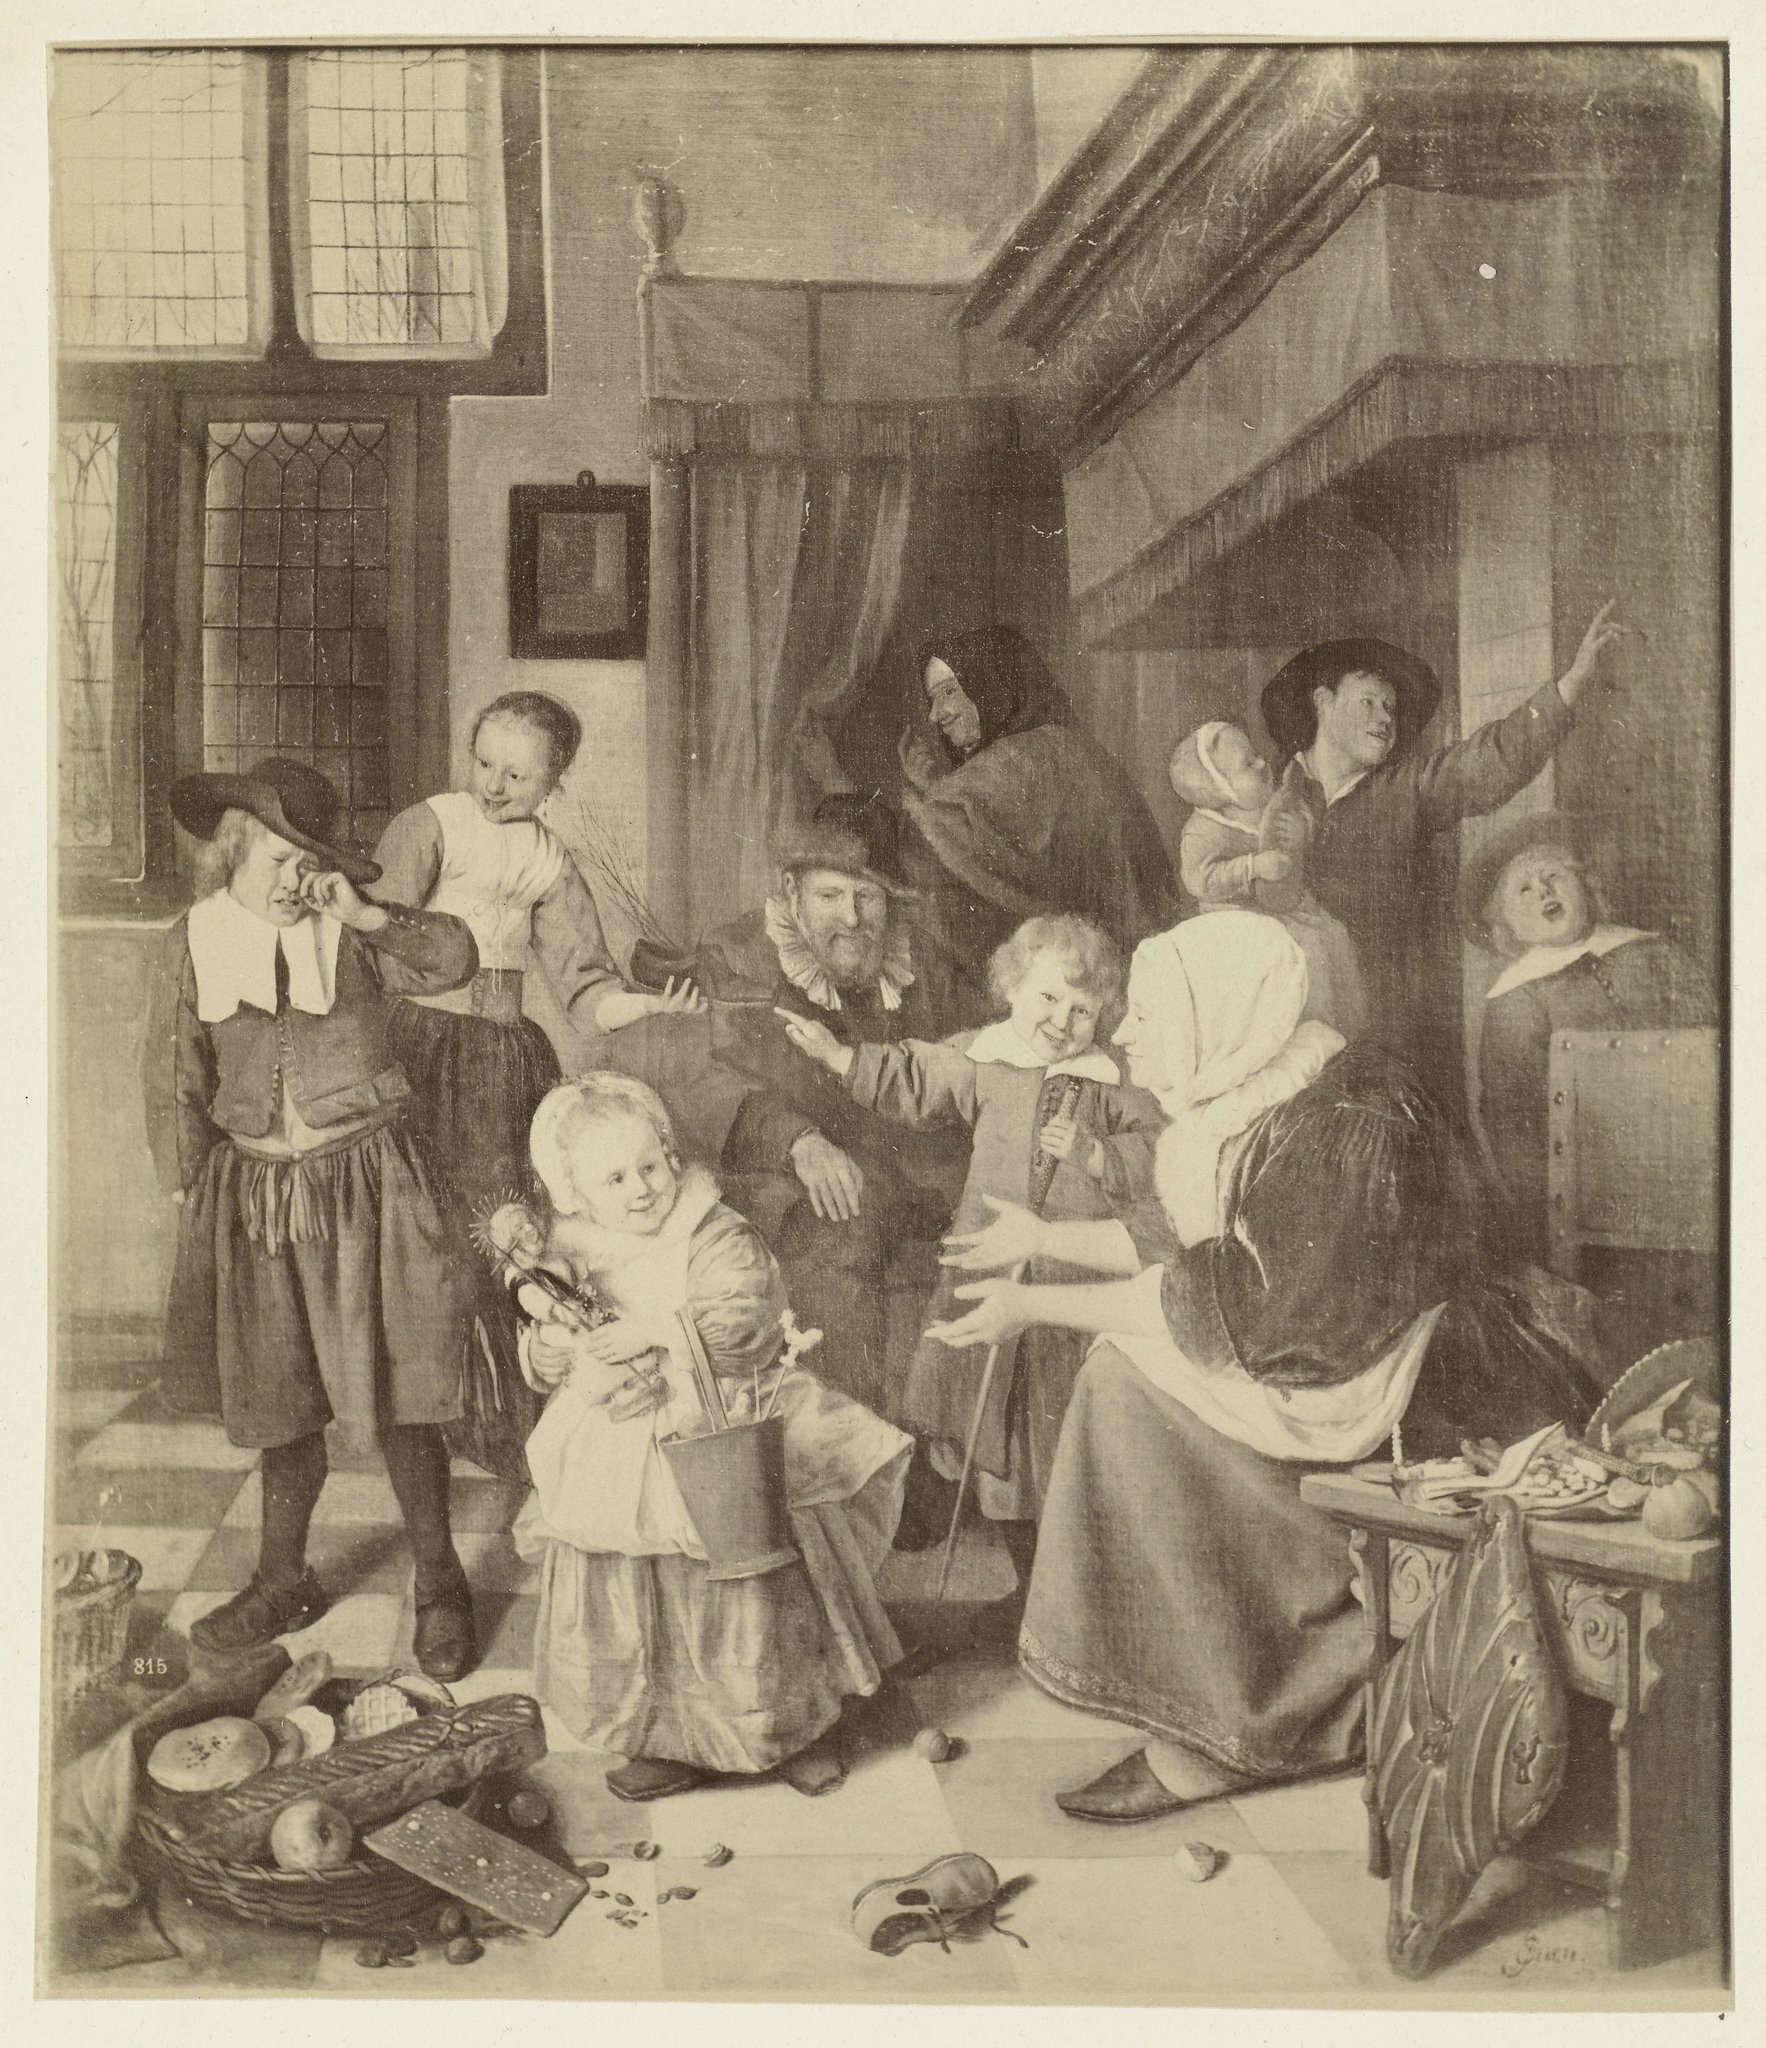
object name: photograph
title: Fotoreproductie van het schilderij Het Sint-Nicolaasfeest door Jan Steen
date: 1867-1880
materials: cardboard, paper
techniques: albumen print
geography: paris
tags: festivities on st. nicholas (eve) (december 5), saint nicholas day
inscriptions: number: ‘815’, inscription: ‘25 Ws’, inscription: ‘J. Steen/ speelgoed/ pop/ Hdf 570/ No. 2237’